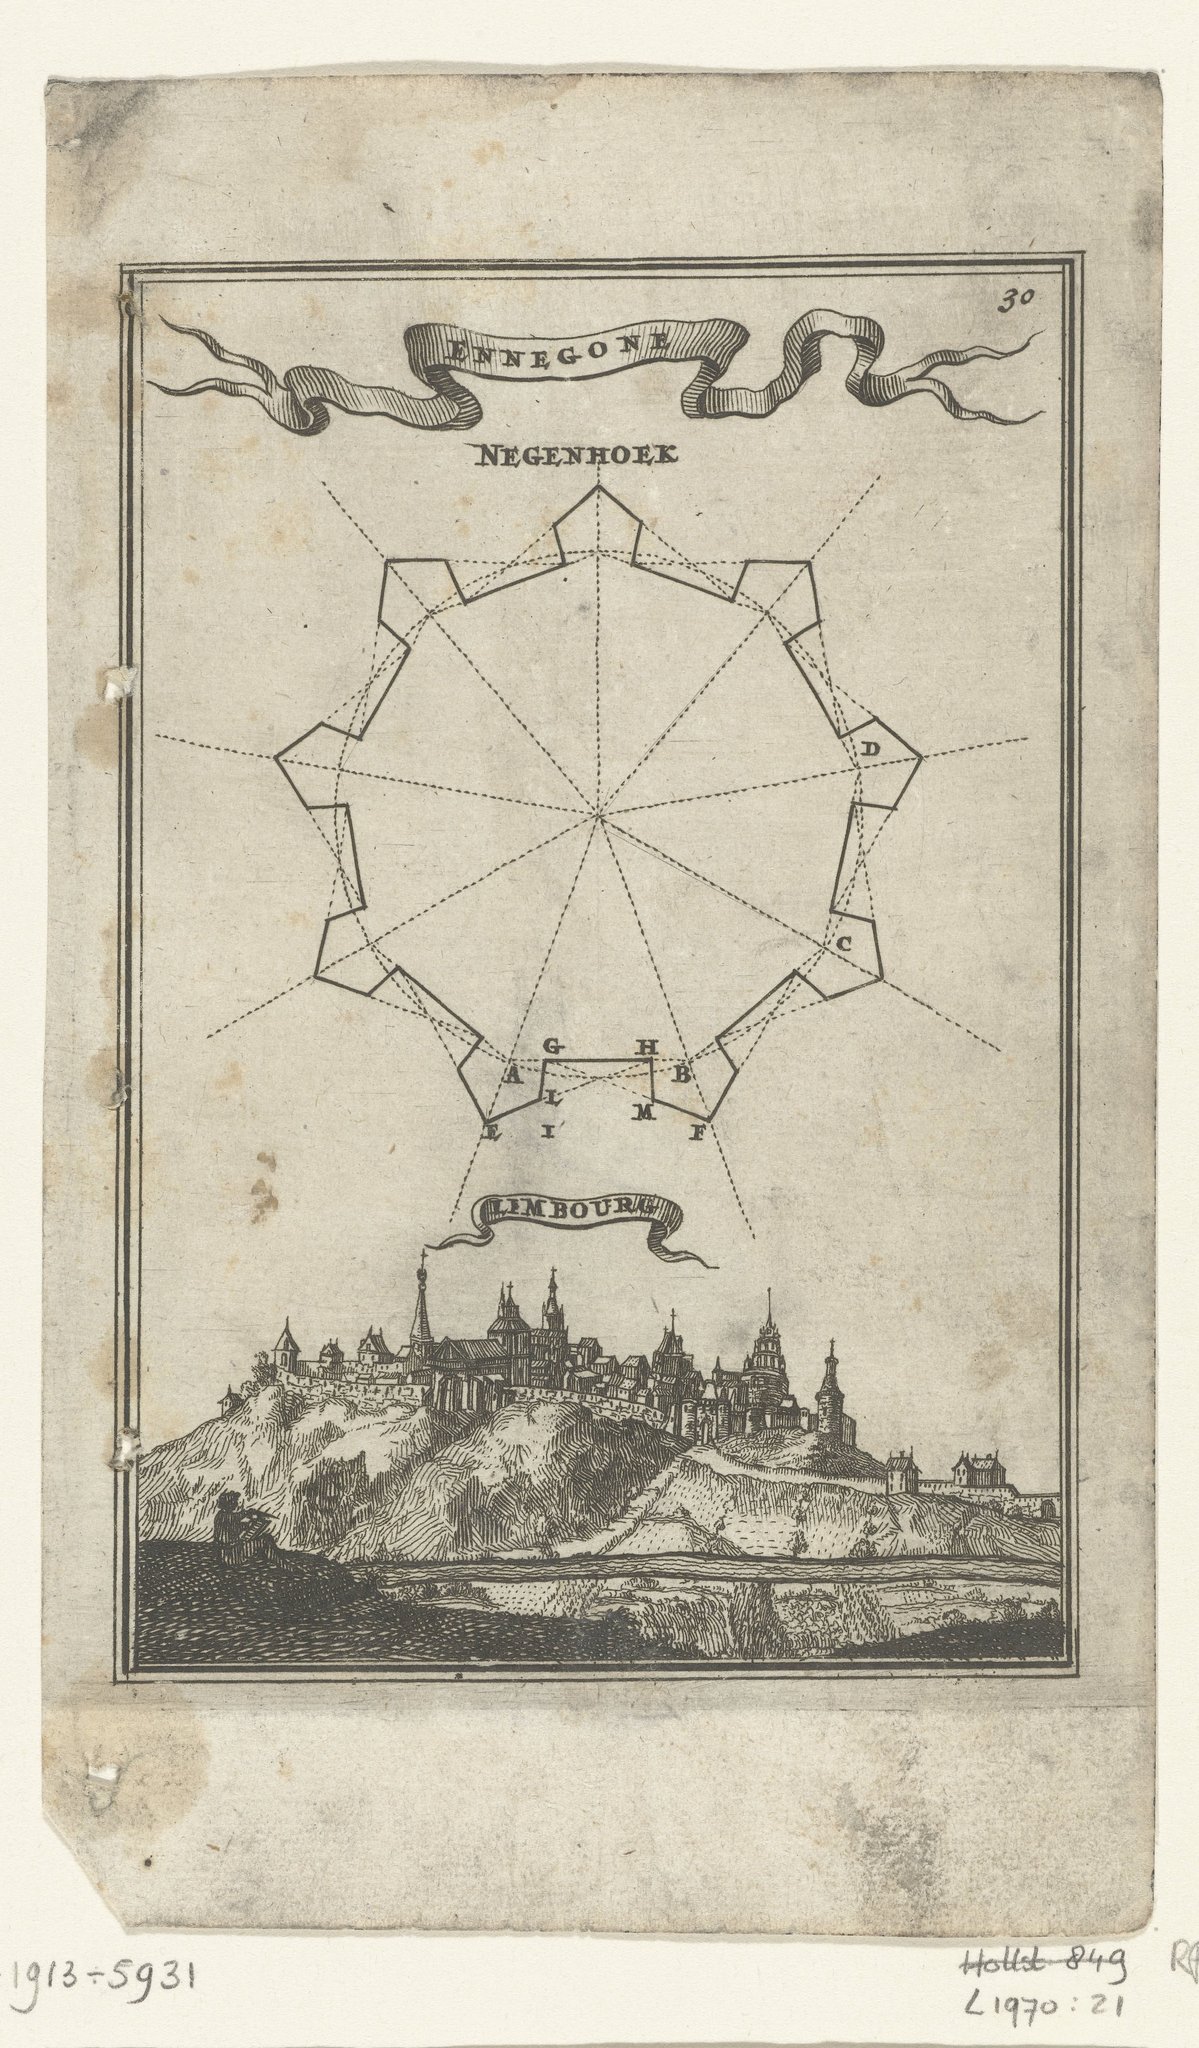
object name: book illustration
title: Illustratie voor 'Den Arbeid van Mars' van Allain Manesson Mallet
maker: romeyn de hooghe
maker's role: draughtsman, goldsmith, painter, print maker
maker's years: 1645-1708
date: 1672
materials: paper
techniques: etching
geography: amsterdam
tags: (high) hill, fortifications, military engineering, prospect of city, town panorama, silhouette of city, mathematics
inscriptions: collector's mark: Lugt 2228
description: Grondplan voor een vesting, fort of versterking (negenhoek). Daaronder een gezicht op een stad op een berg (Limbourg). In de hoek rechtsboven het cijfer 30 (= het nummer van de pagina in het boek waartegenover de illustratie geplaatst is).